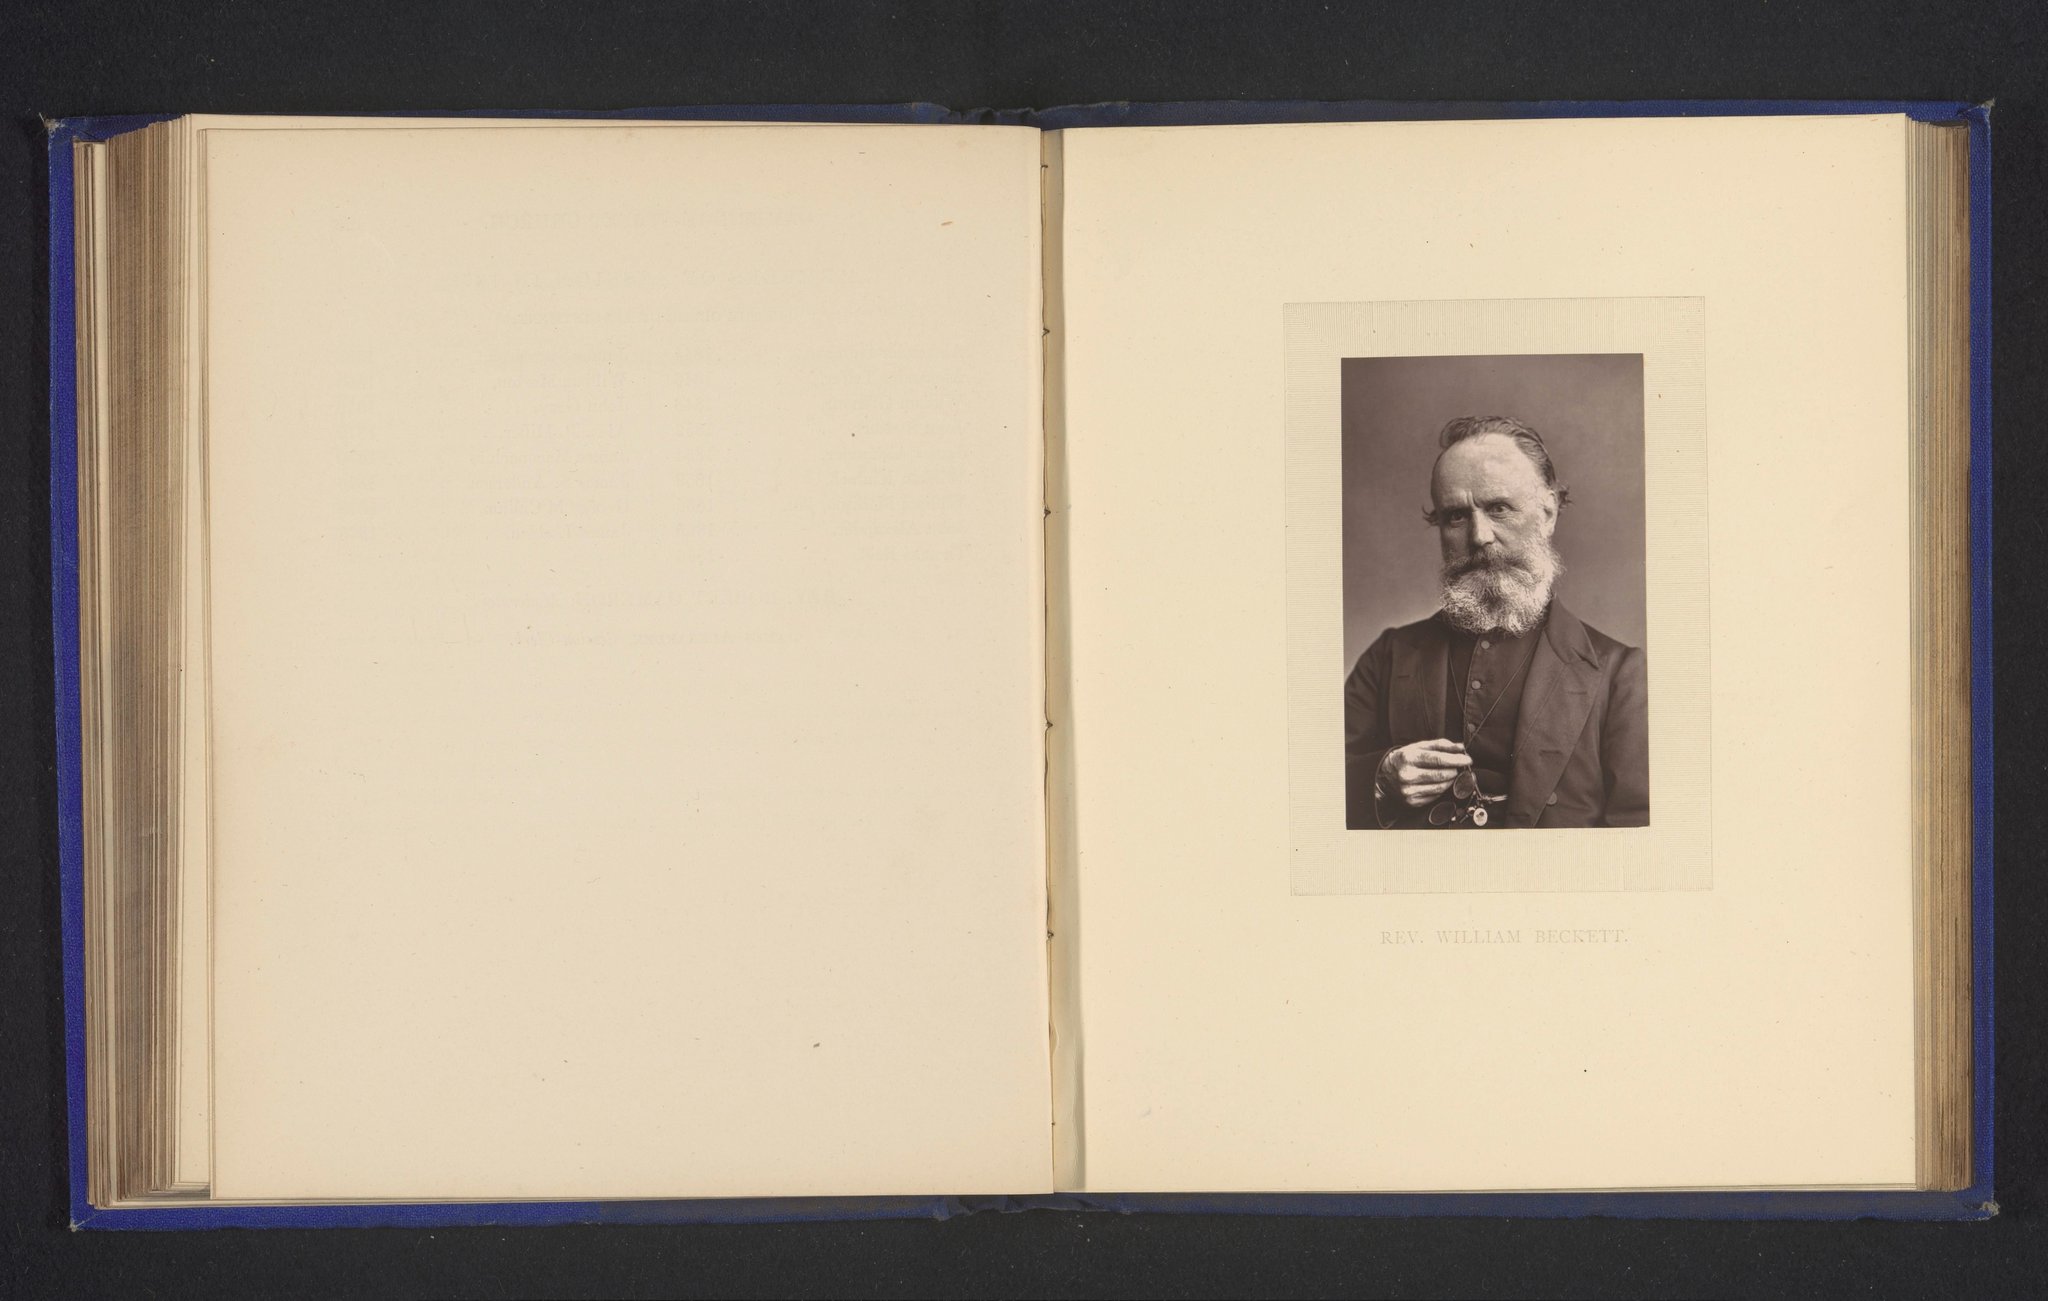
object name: photomechanical print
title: Rev. William Beckett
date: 1865-1875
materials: paper, photographic support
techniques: carbon print, woodburytype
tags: functionaries and dignitaries (with name) ~ protestant churches